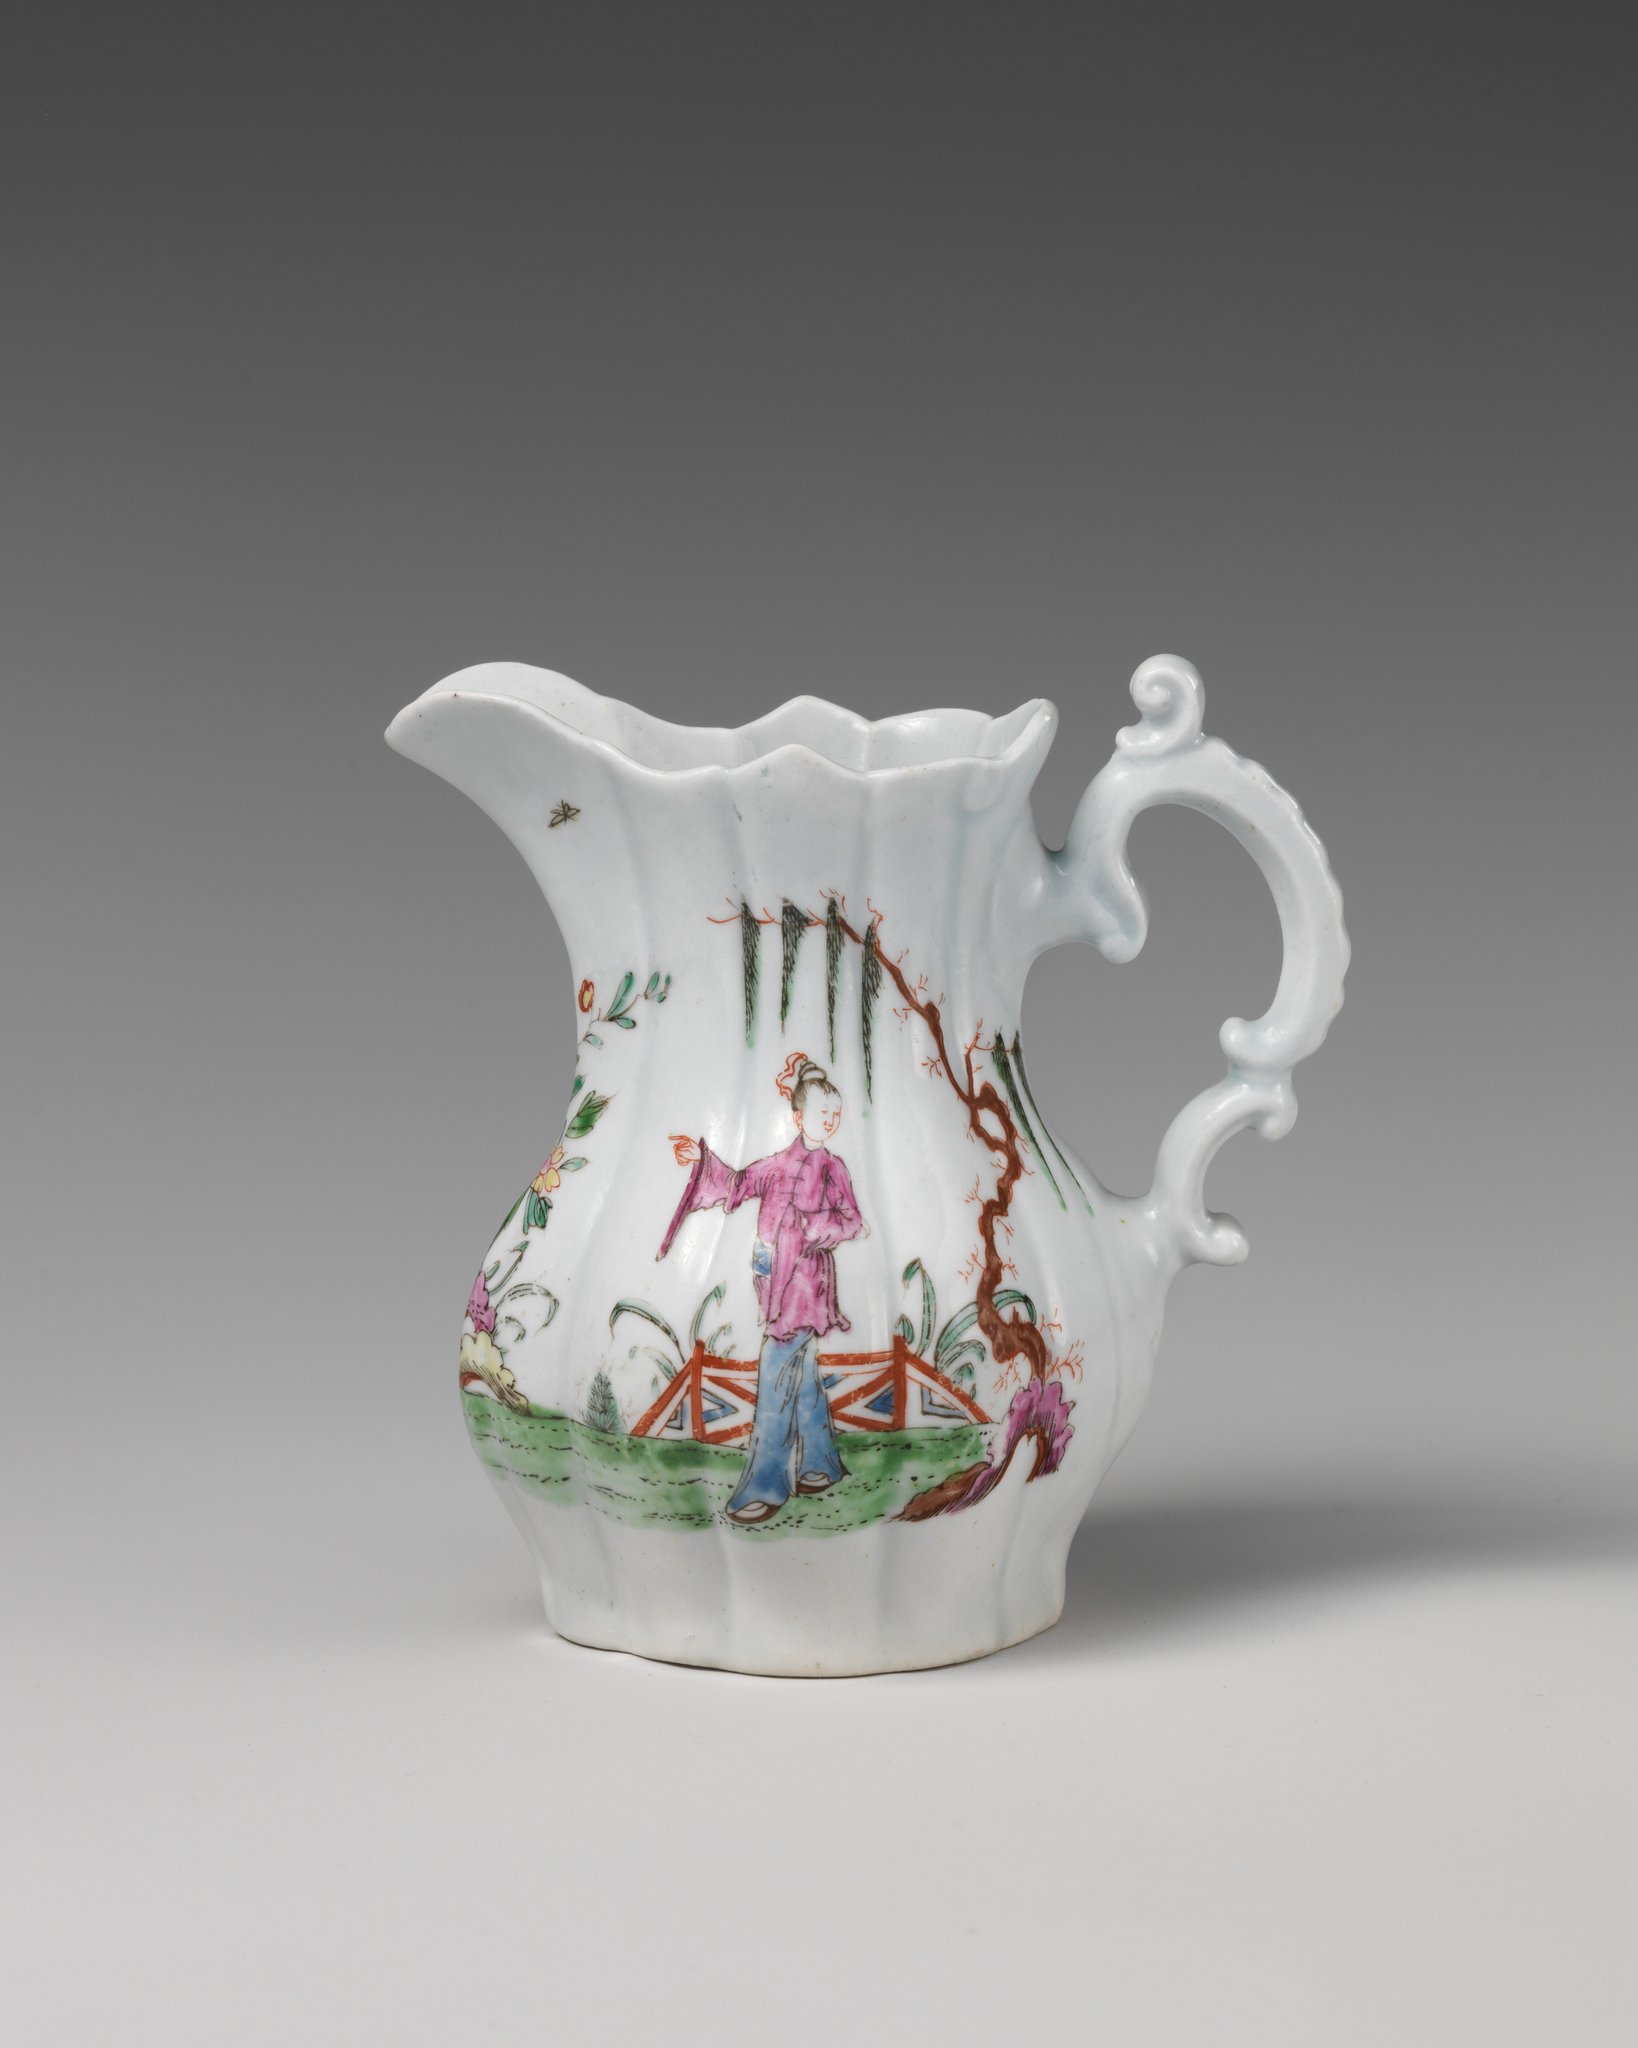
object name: cream jug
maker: worcester factory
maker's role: factory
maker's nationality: british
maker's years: 1751-2008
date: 1753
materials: soft paste porcelain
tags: chinoiserie